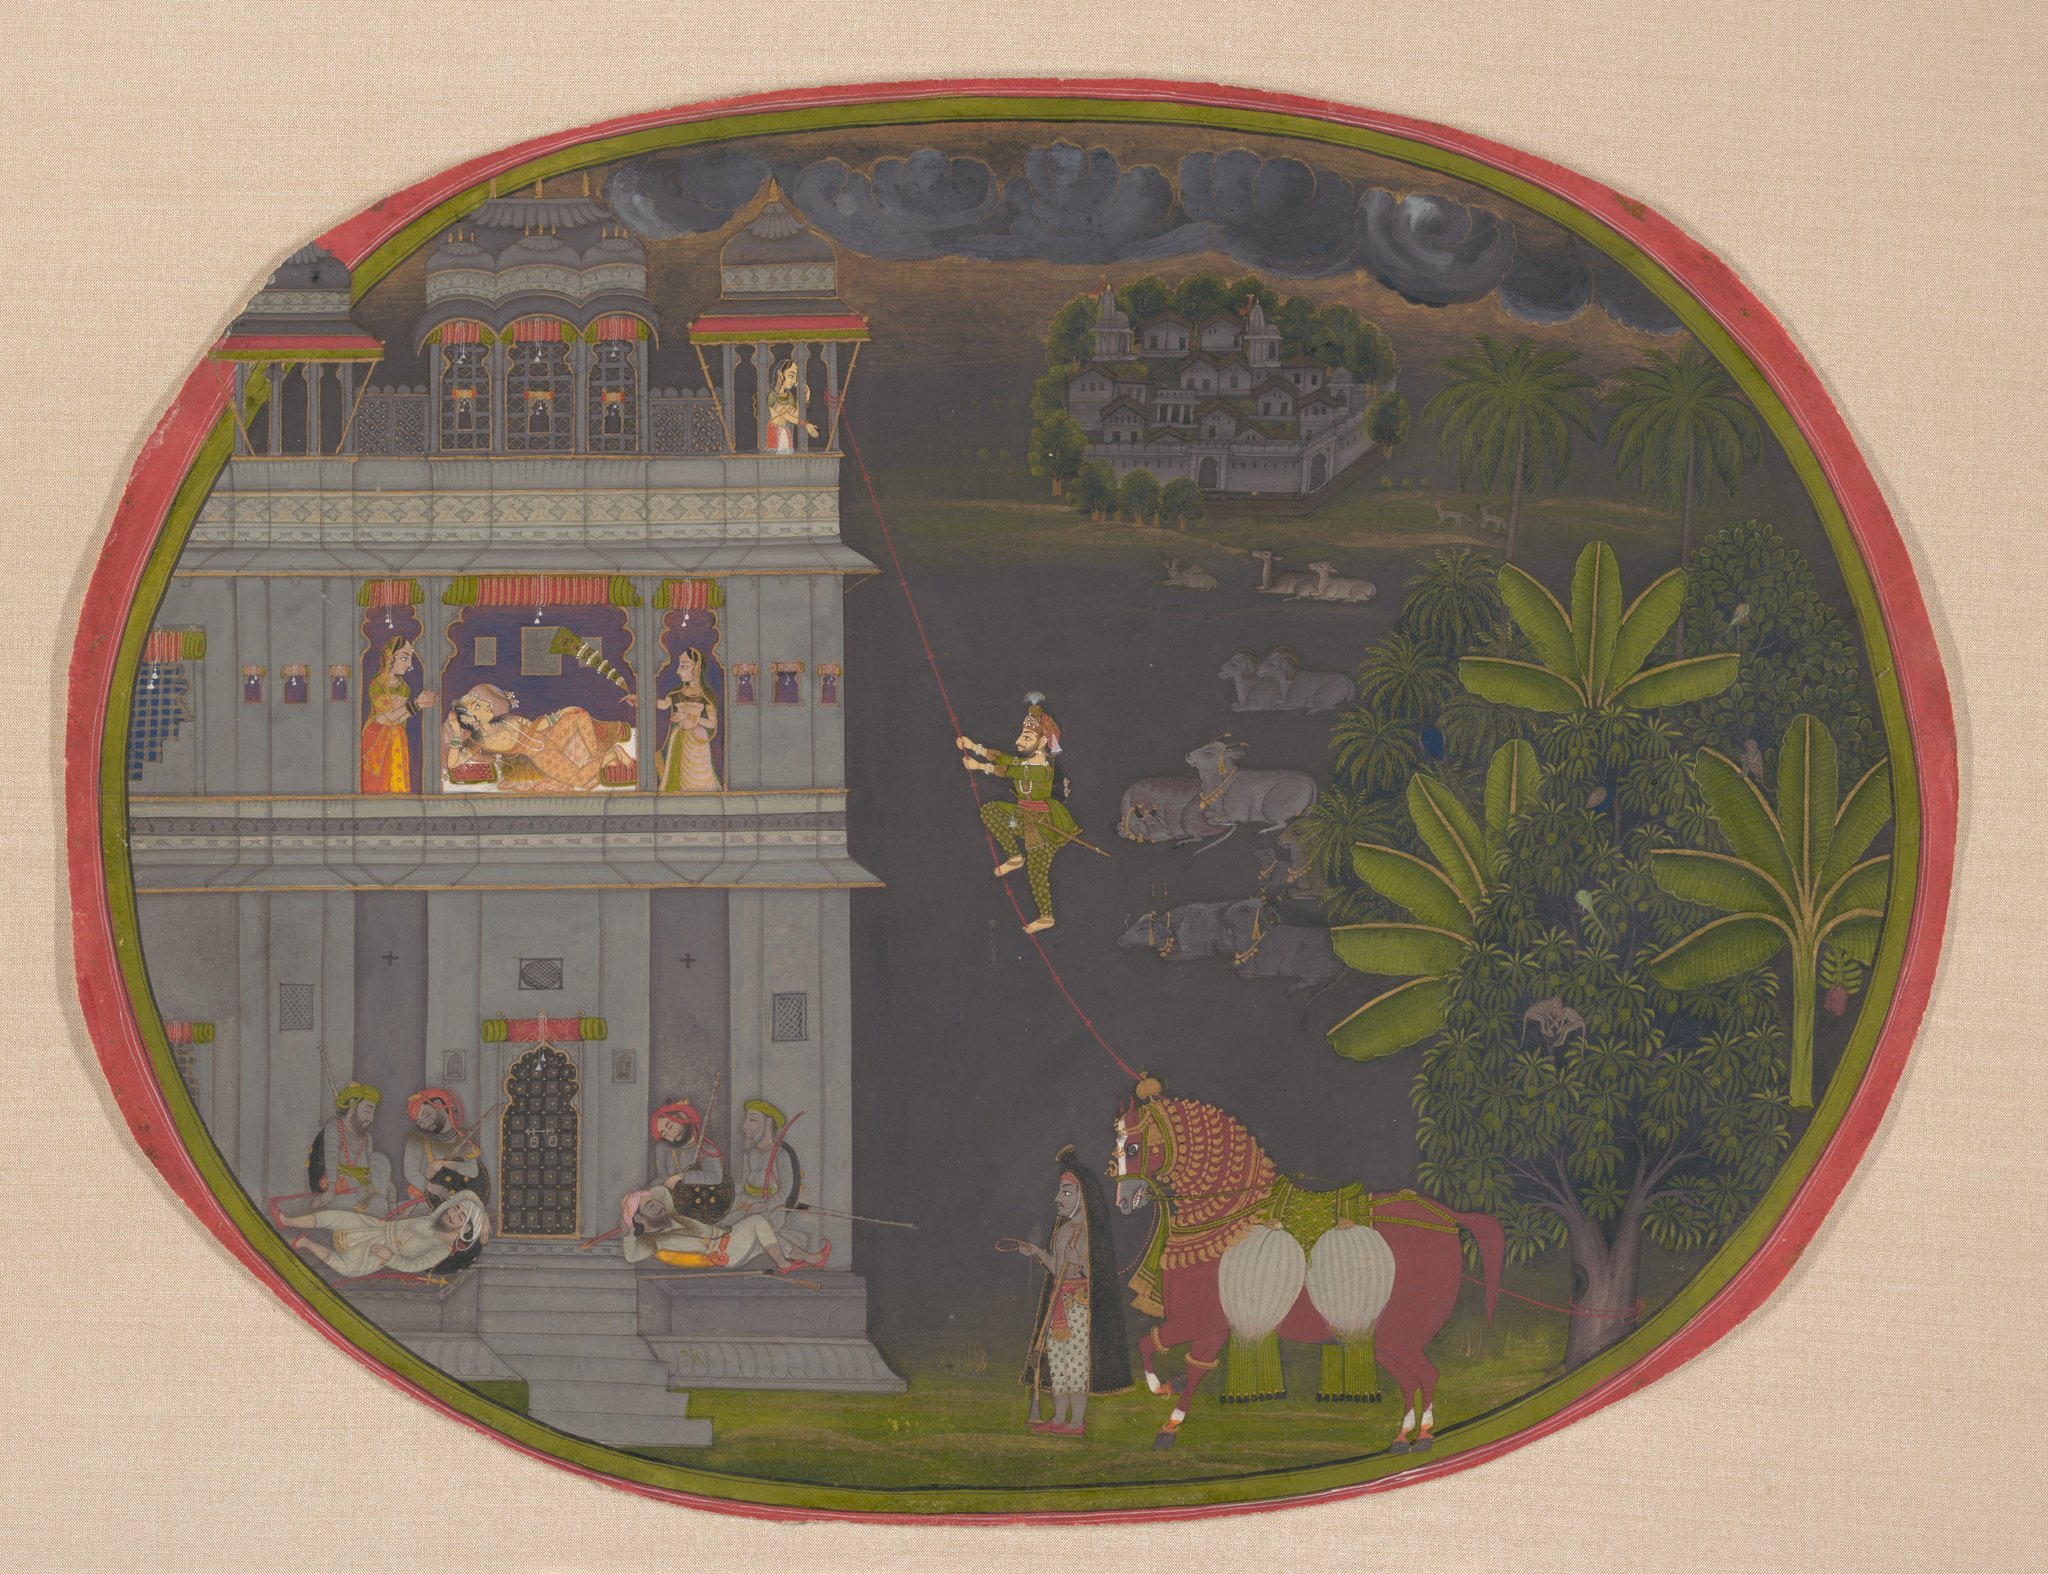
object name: painting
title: Escapade at Night:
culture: mewar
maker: chokha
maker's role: artist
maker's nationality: indian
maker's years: 1799-1826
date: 1800-1810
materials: gold, ink, paper, watercolor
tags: palaces,sleeping,men,women,cows,horses,night